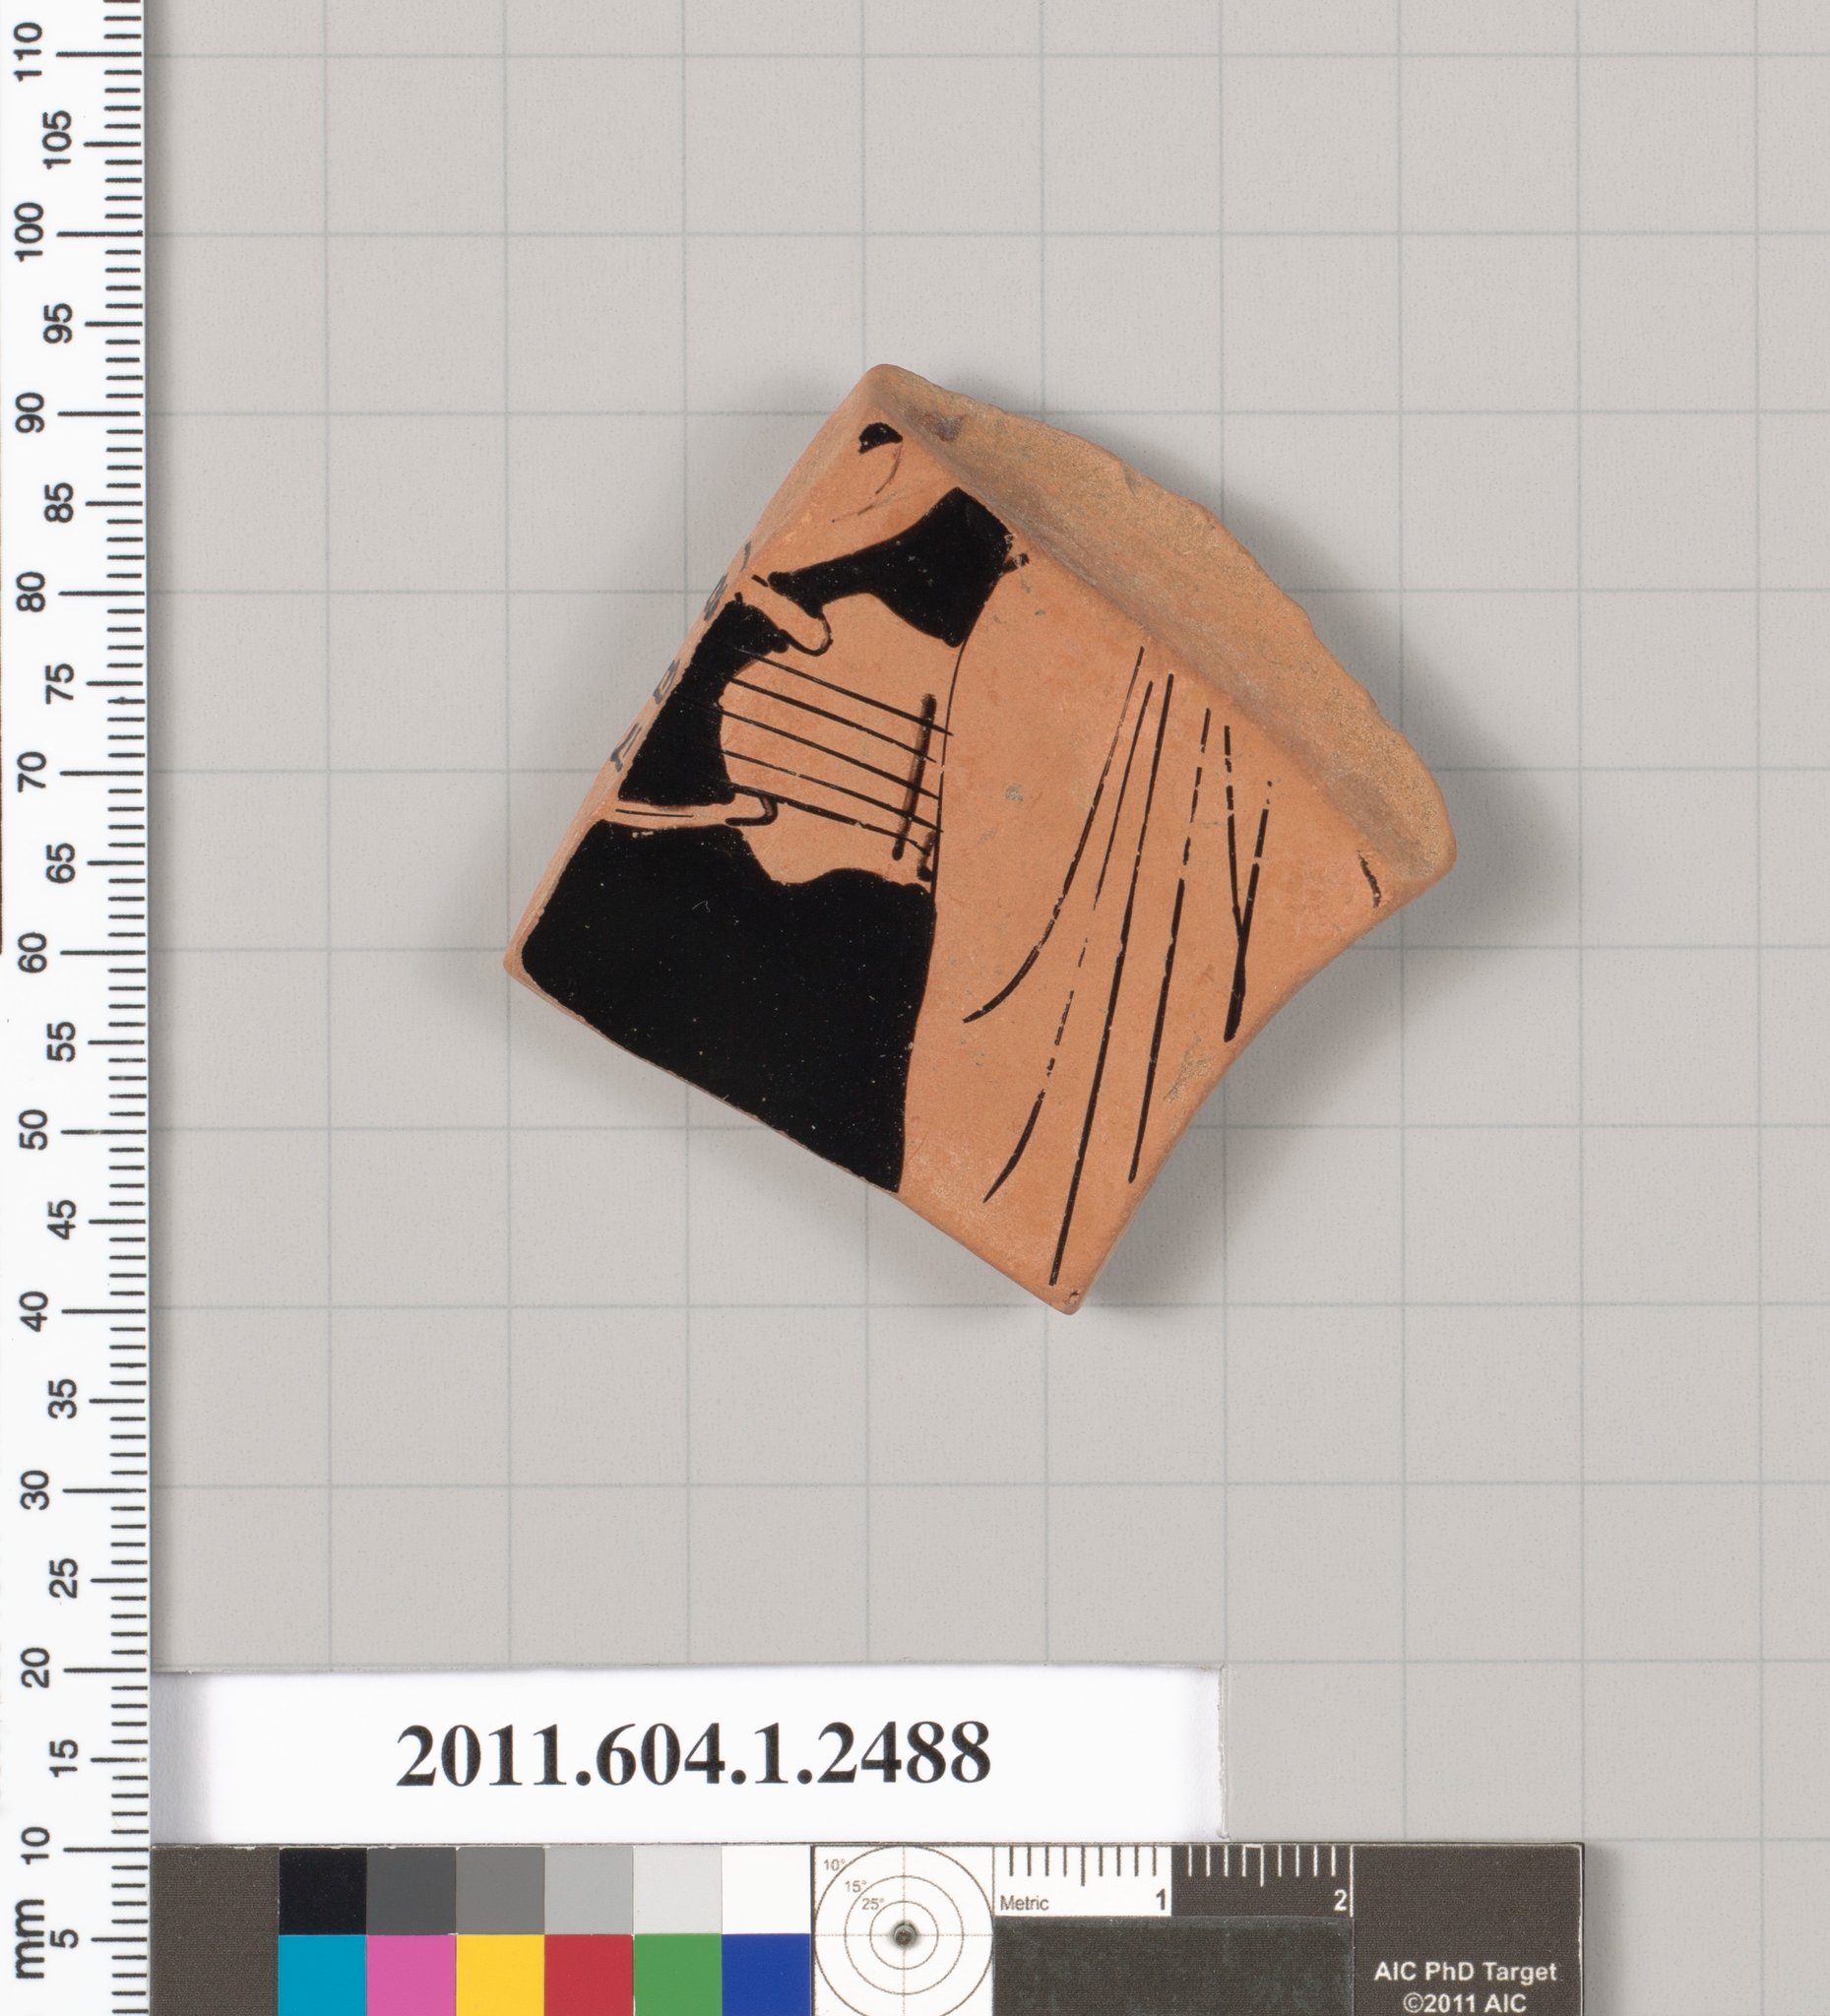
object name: kylix fragment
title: Terracotta fragment of a kylix (drinking cup)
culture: greek, attic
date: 475-451 BCE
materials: terracotta